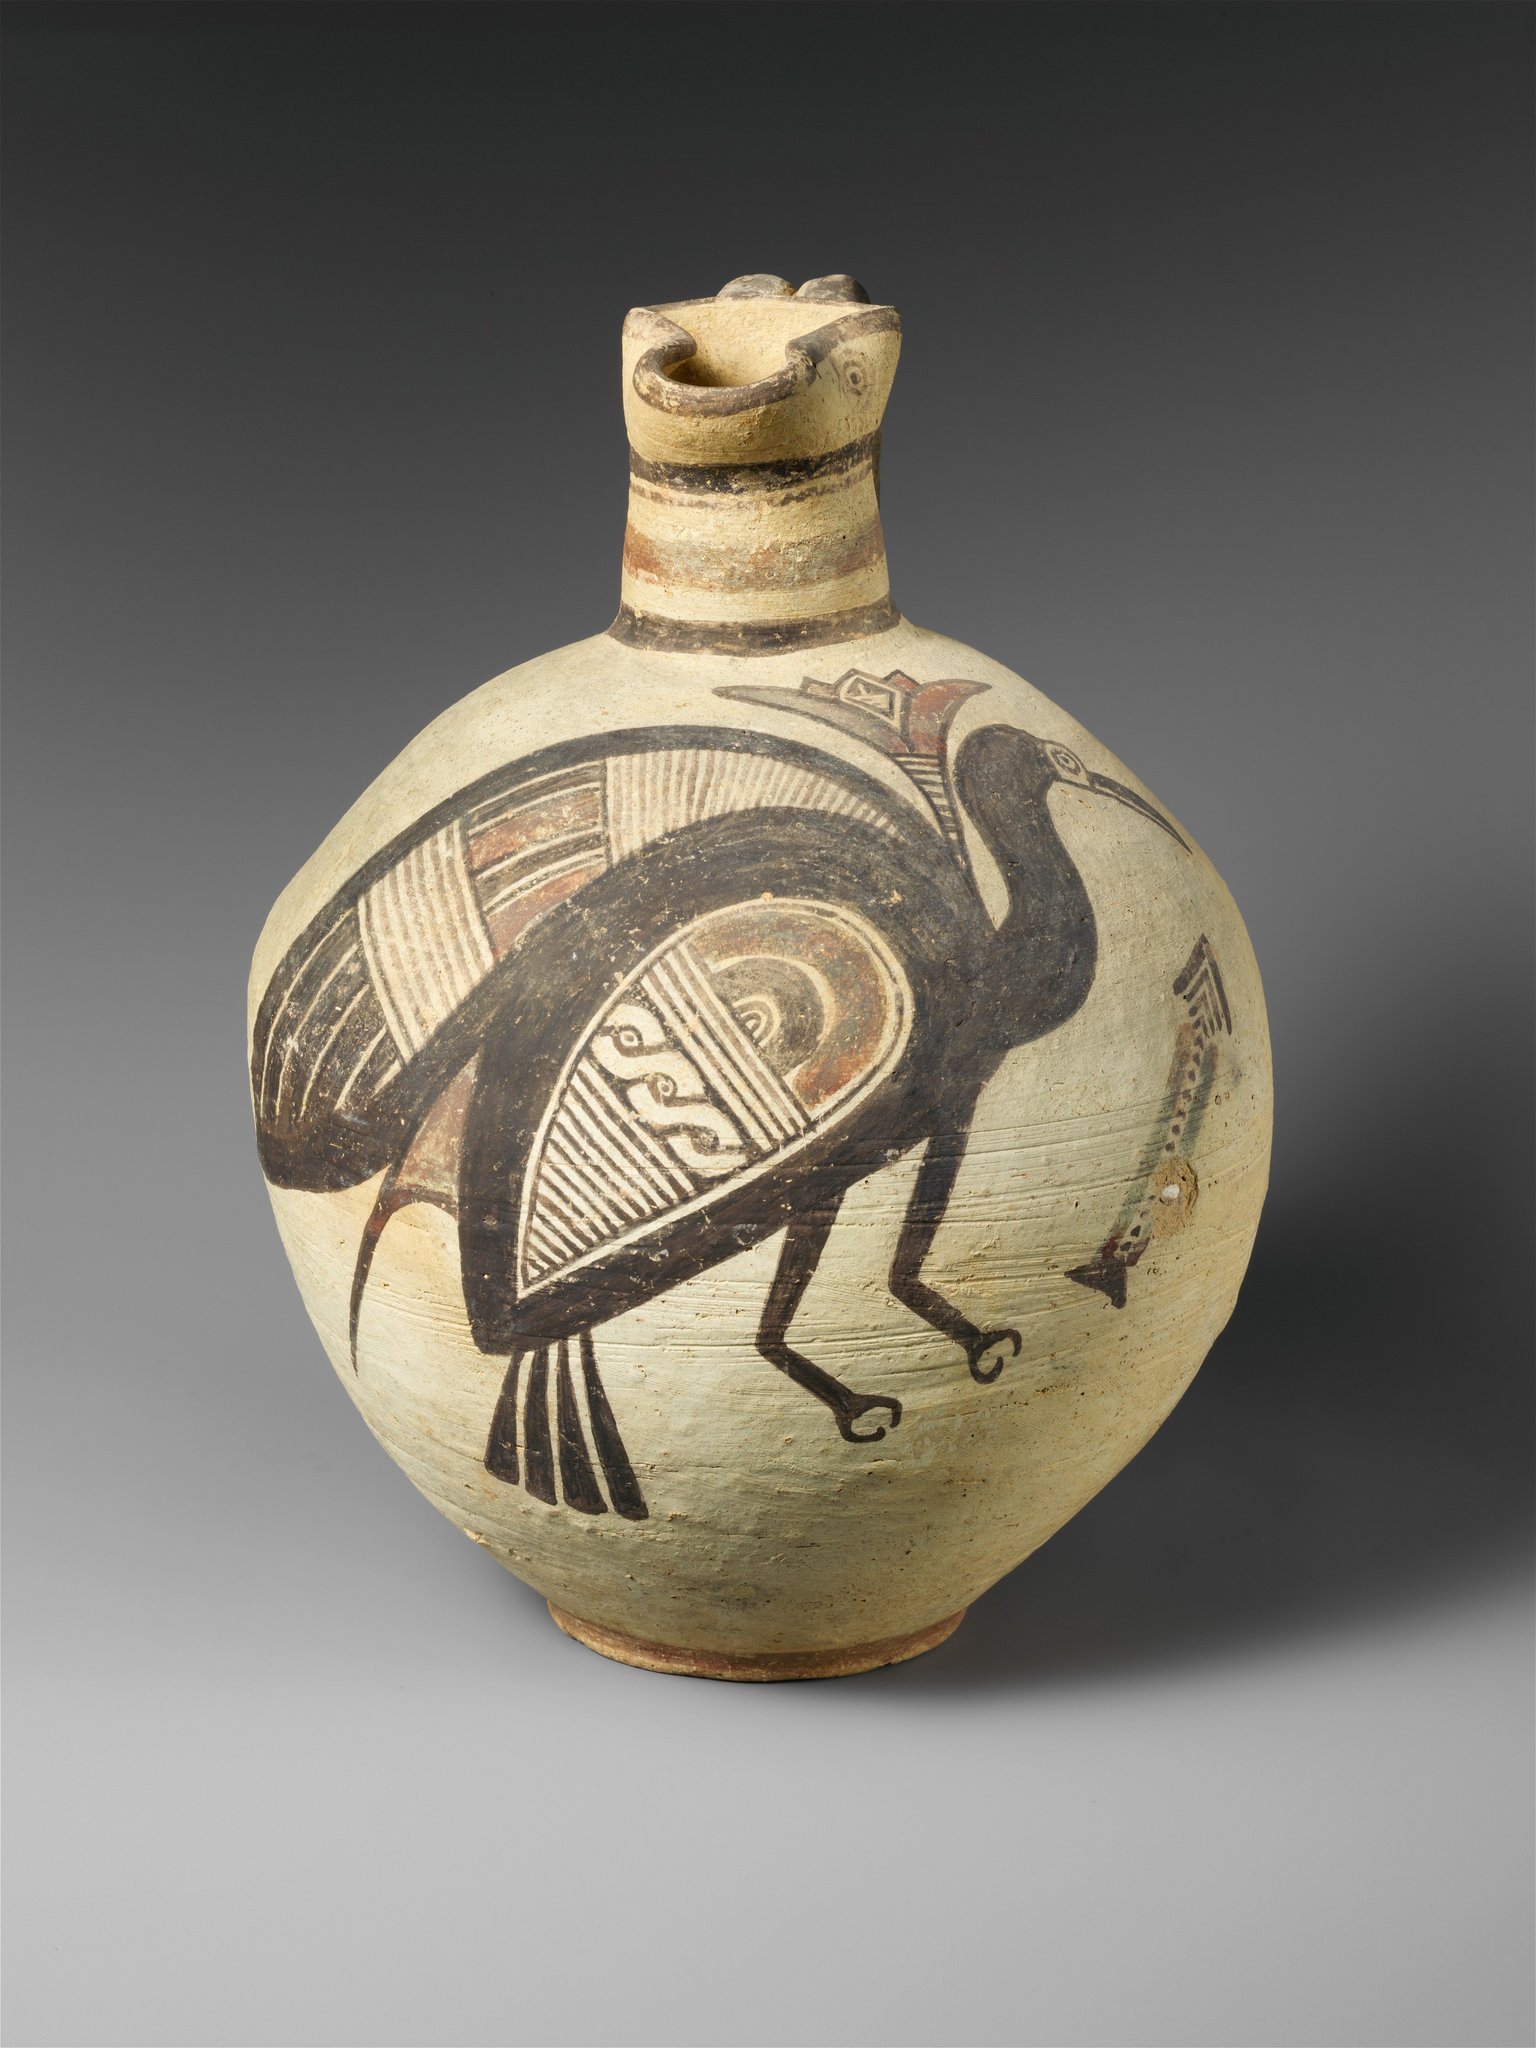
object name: jug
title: Terracotta jug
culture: cypriot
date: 750-600 BCE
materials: terracotta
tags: birds